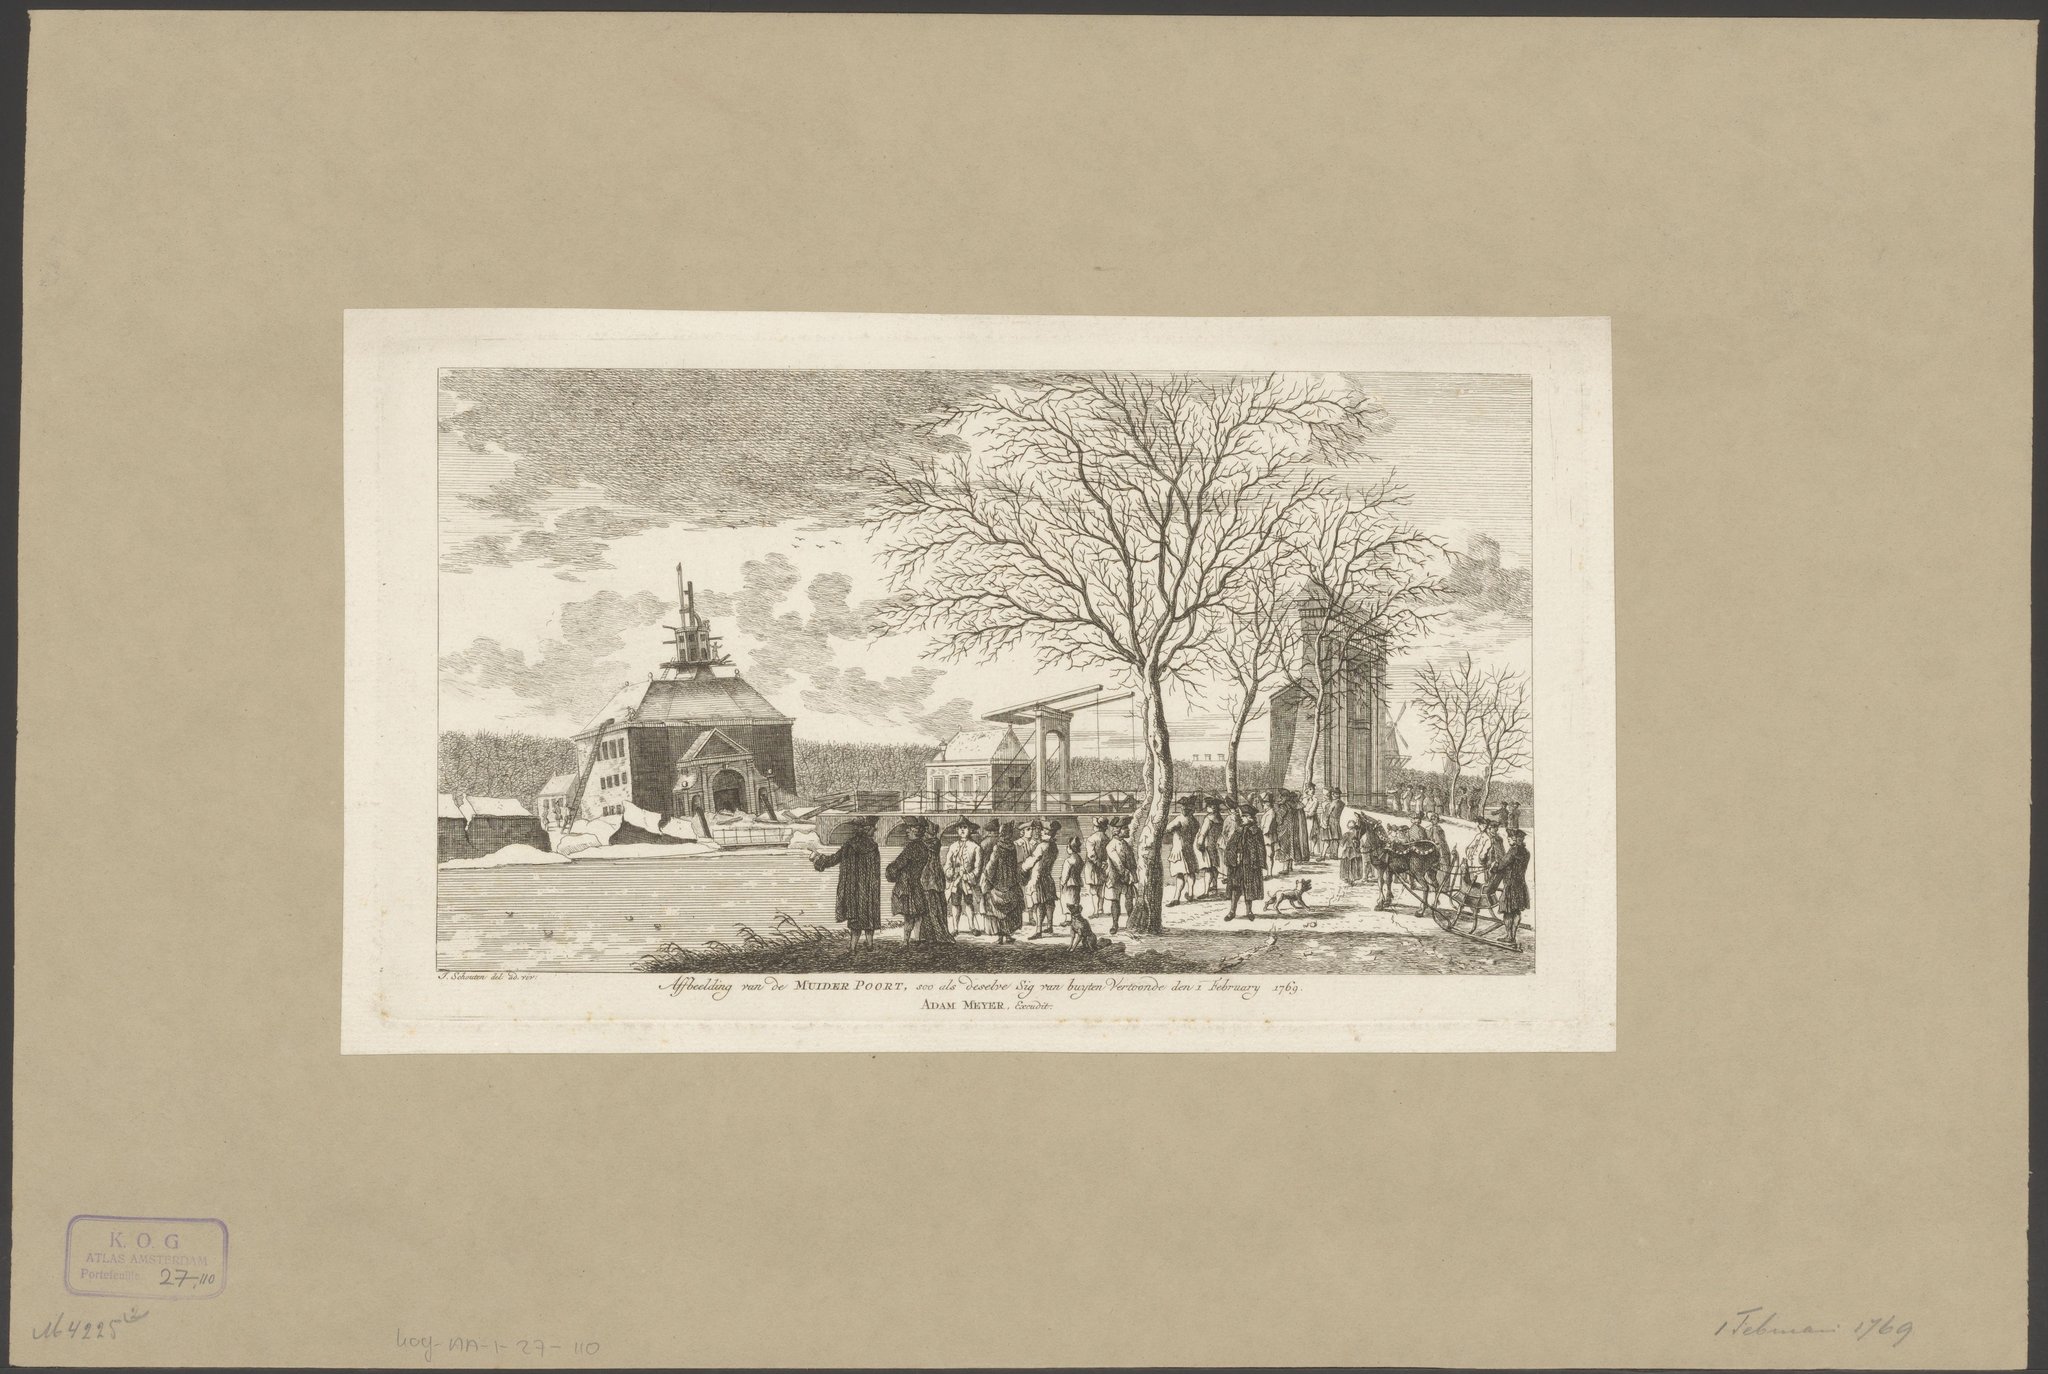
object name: print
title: Gezicht op de zijkant van de verzakte Eerste Muiderpoort in Amsterdam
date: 1769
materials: paper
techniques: engraving, etching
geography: amsterdam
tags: city-gate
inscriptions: collector's mark: Lugt 1641b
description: Sloop van de verzakte Muiderpoort te Amsterdam, gezien vanaf de Plantage. Op de voorgrond volgen toeschouwers het begin van de sloopwerkzaamheden, 1 februari 1769. Onderwerpsrubriek binnen de Atlas Amsterdam: Poorten, verzamelbladen, H. Ingezakte Muiderpoort.